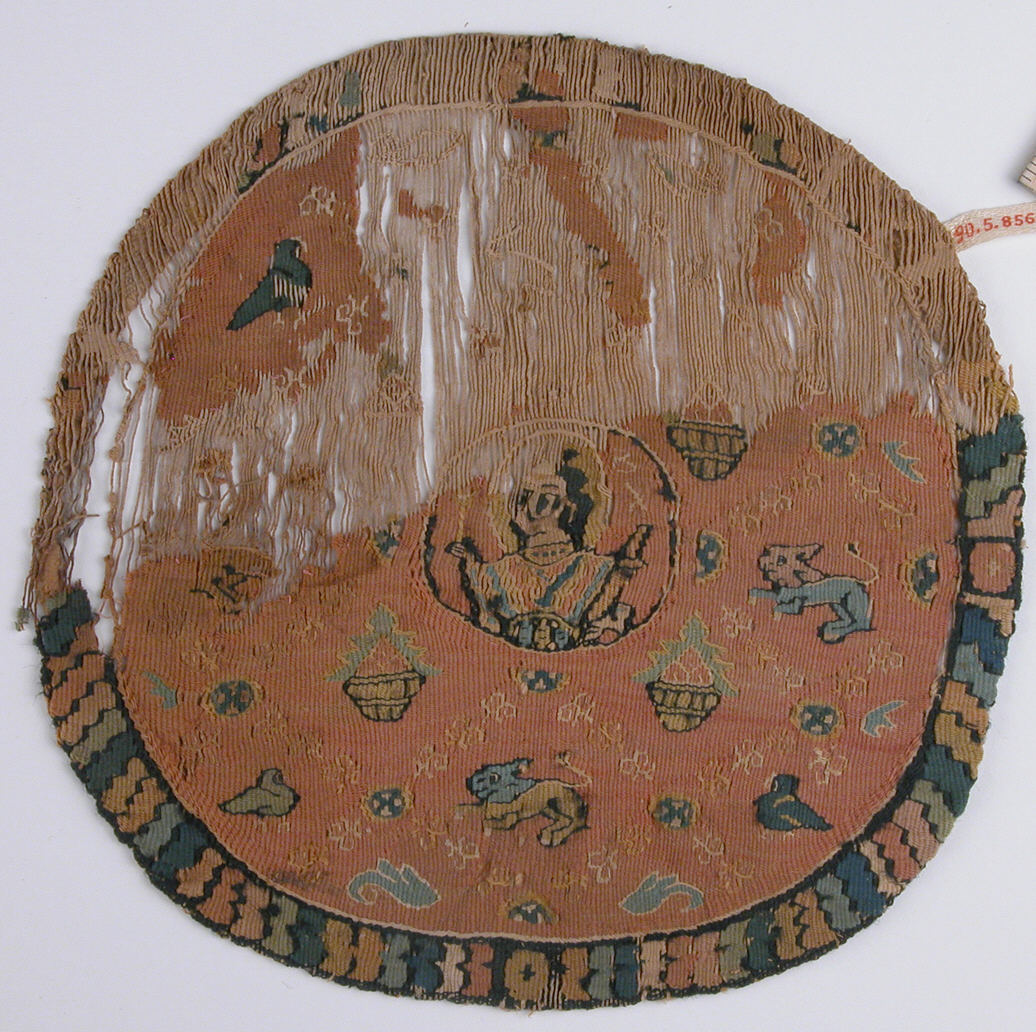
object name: roundel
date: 501-700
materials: linen, wool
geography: egypt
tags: human figures,animals,birds